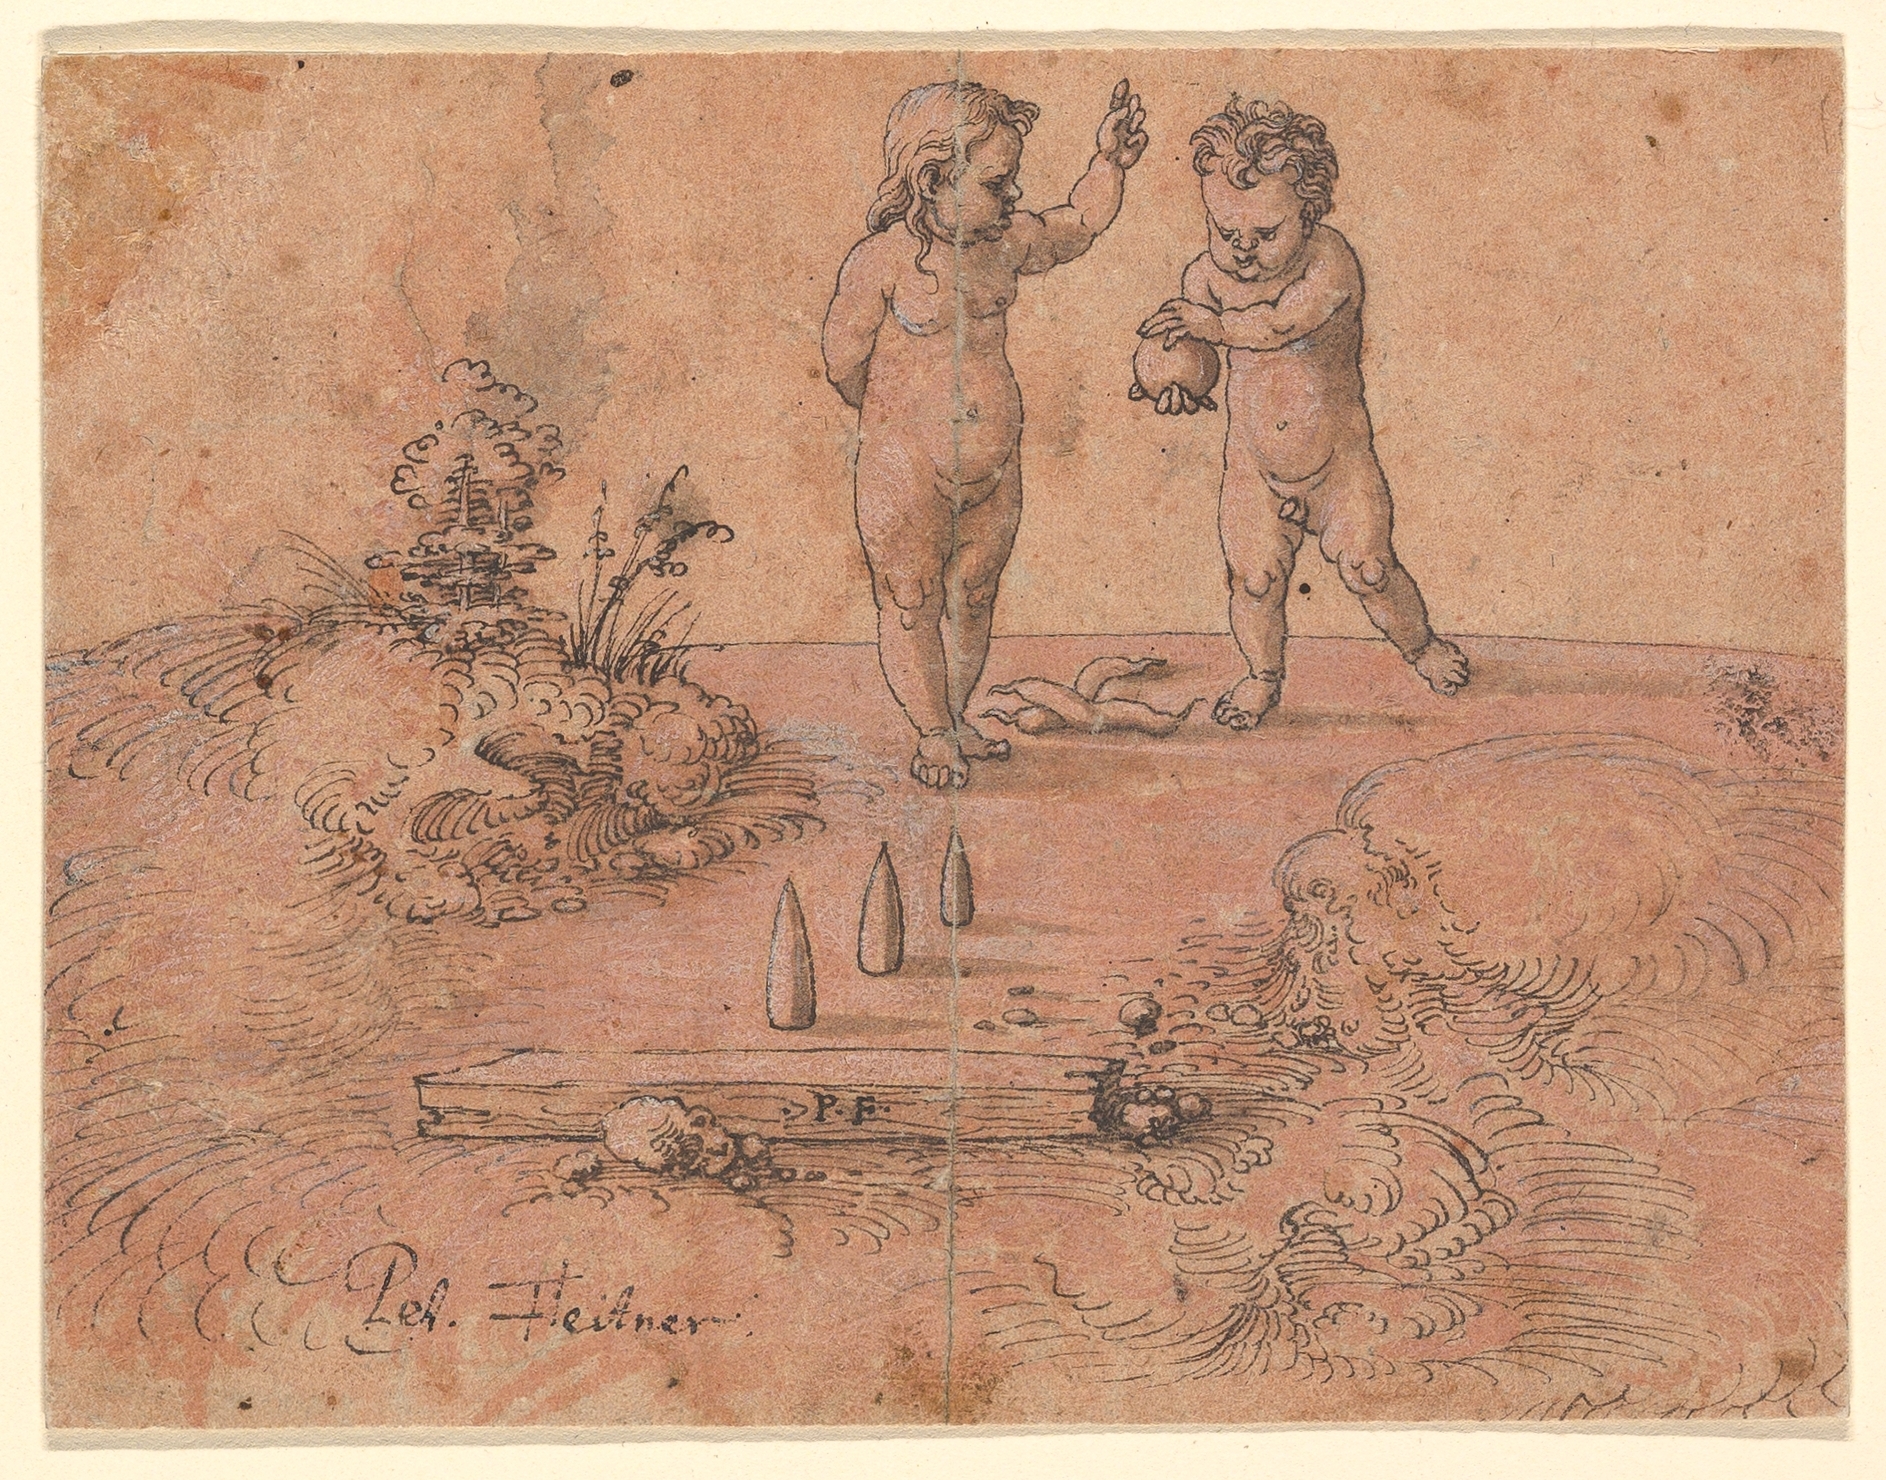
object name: drawing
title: Two Children Playing with a Ball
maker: peter flötner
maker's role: artist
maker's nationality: german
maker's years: 1485-1546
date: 1500-1546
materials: paint, ink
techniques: brush, heightening, pen, wash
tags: children,playing